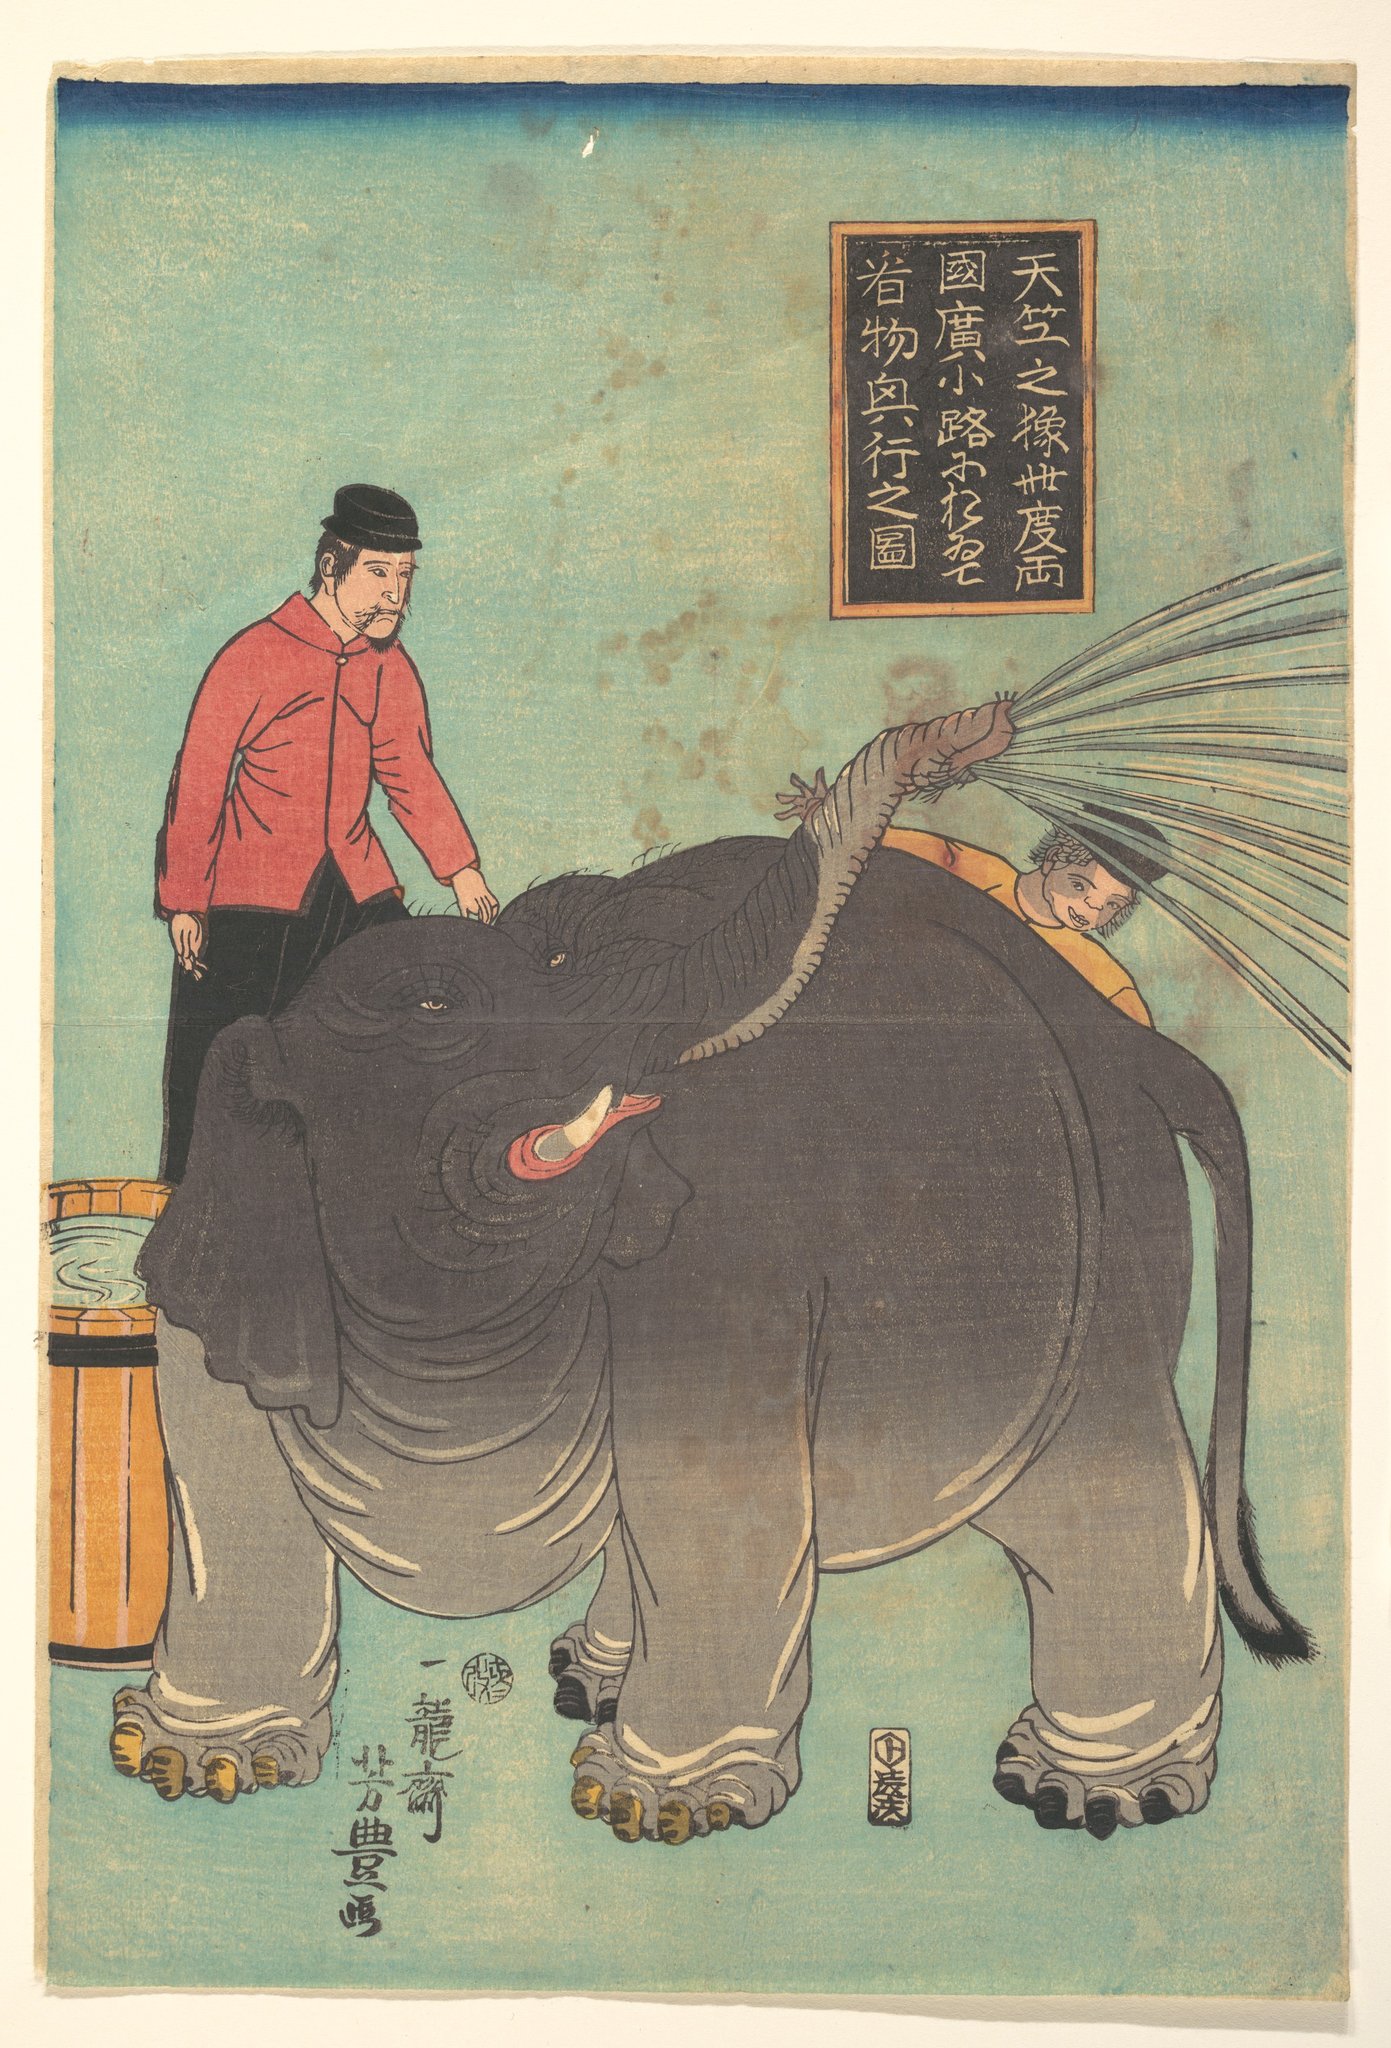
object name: print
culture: japanese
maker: ichiryūsai yoshitoyo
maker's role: artist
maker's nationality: japanese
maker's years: 1830-1866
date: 1863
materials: ink, paper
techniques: woodblock print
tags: men,elephants